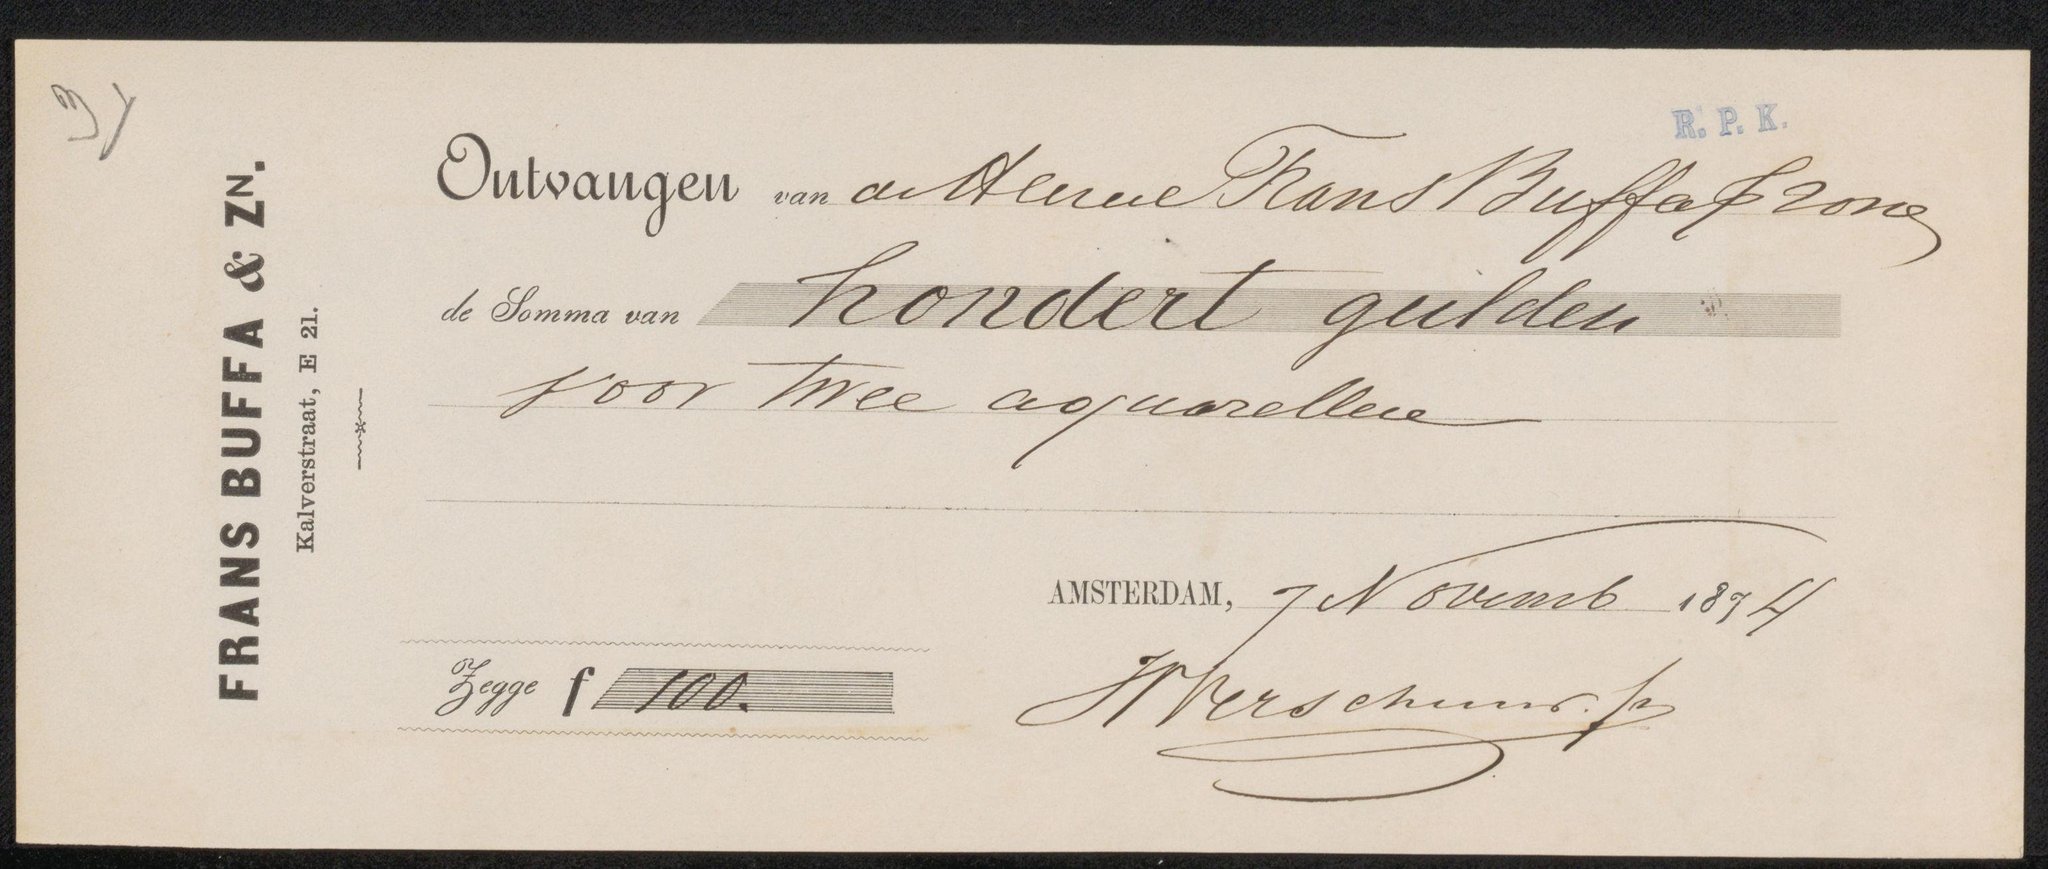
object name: ontvangstbewijs, kwitantie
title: Kwitantie voor Wouter Verschuur (1841-1936)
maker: wouter verschuur (1841-1936)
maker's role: draughtsman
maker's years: 1841-1936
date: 1874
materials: ink, paper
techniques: pen, printing, writing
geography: amsterdam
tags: drawing, money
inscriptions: collector's mark: Lugt 2233